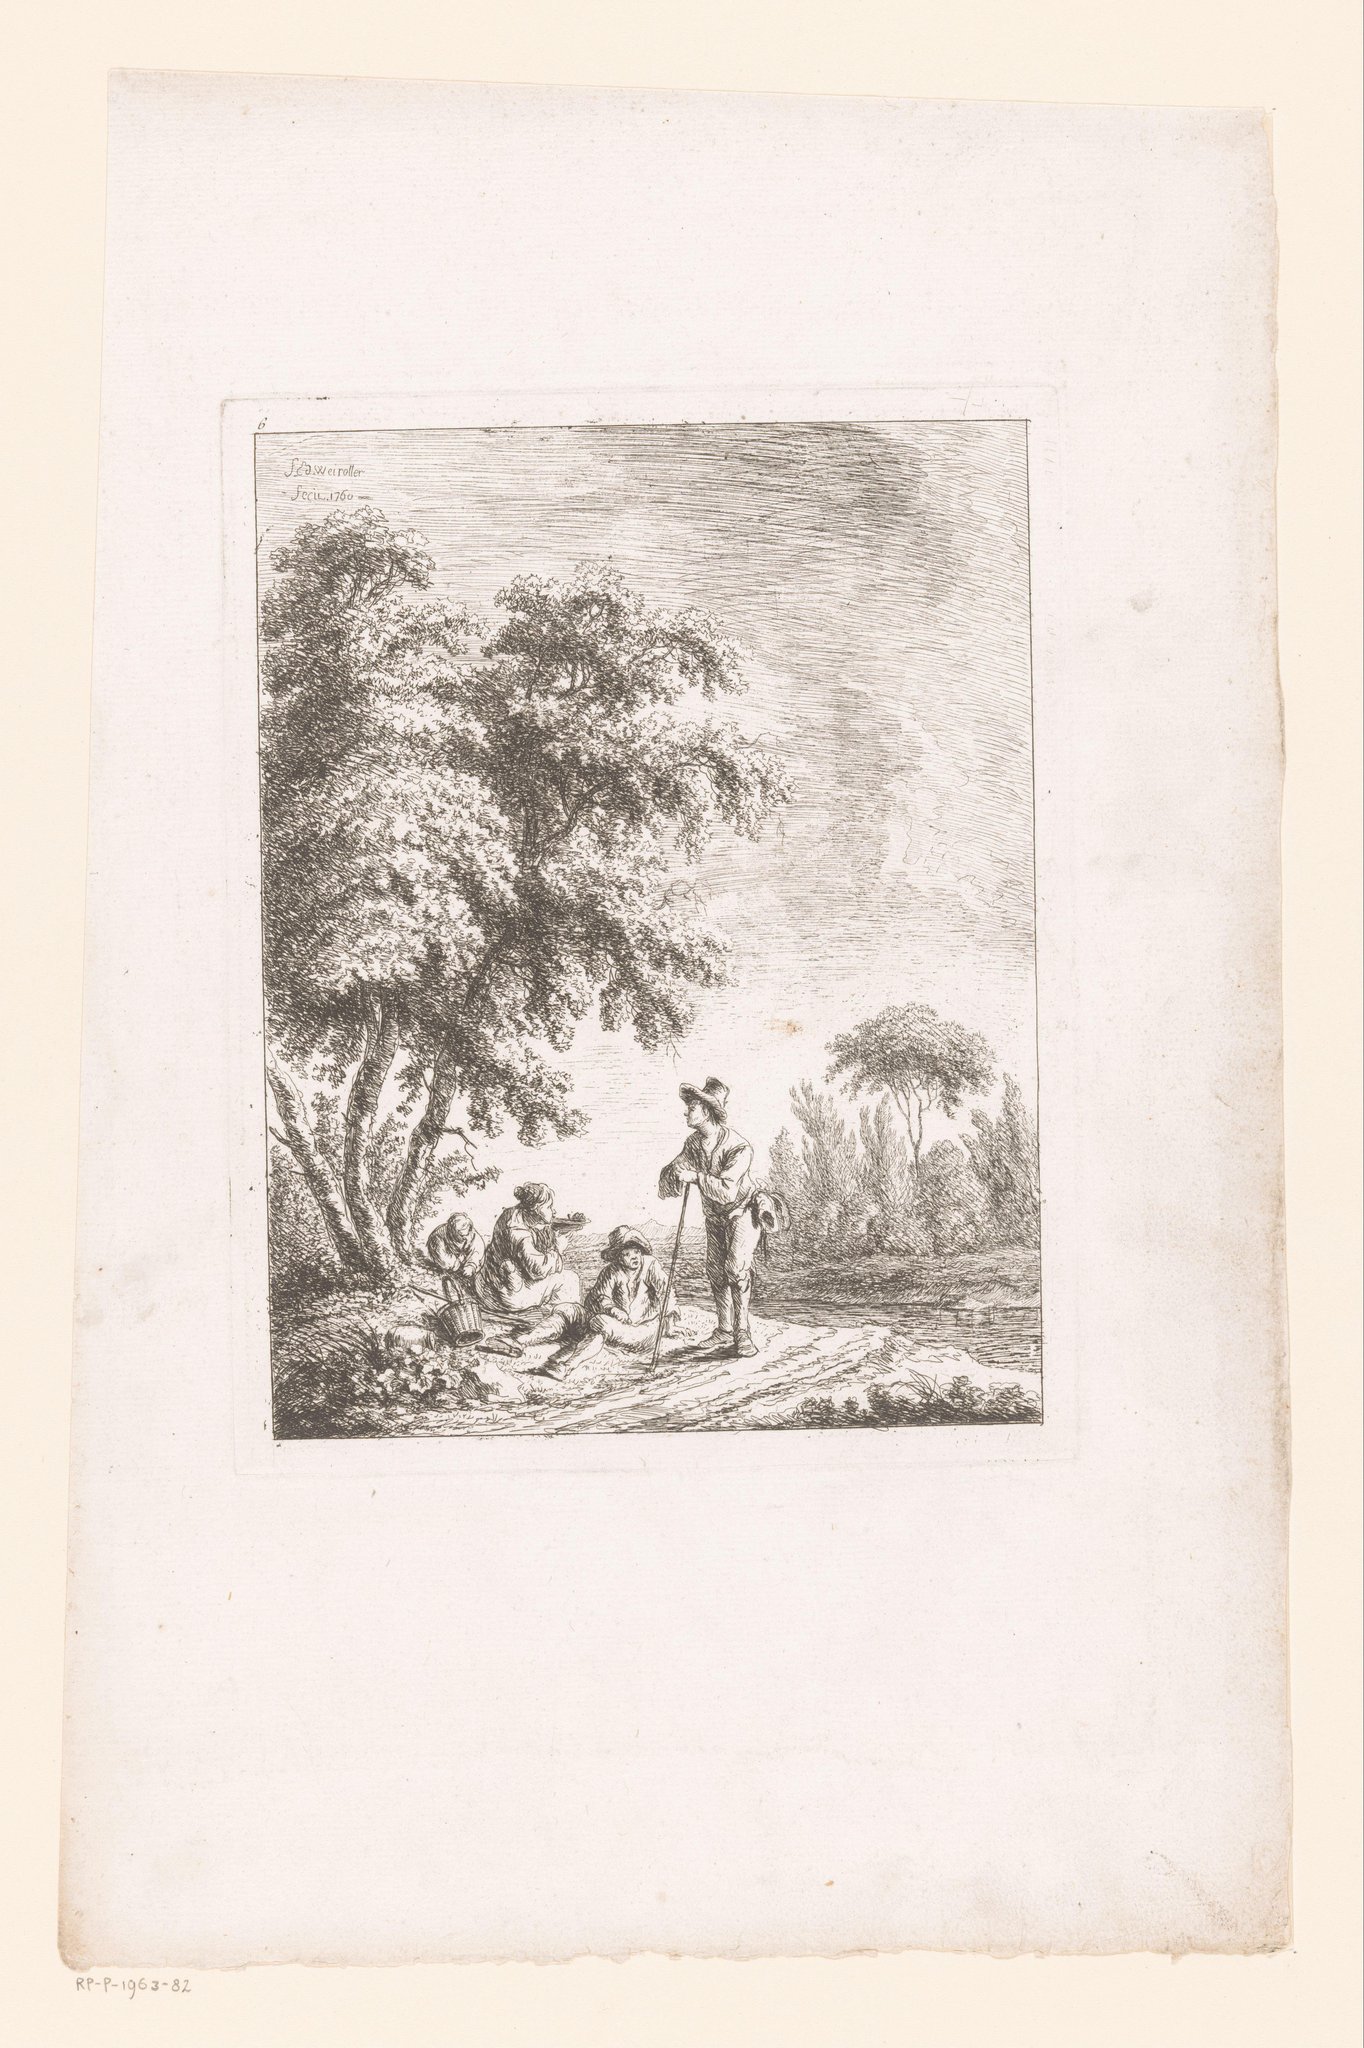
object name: print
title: Deuxième suite des ruines et paysages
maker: franz edmund weirotter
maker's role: draughtsman, painter, print maker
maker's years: 1733-1771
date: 1760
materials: paper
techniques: etching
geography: paris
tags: river, (traveller) resting in the open air, container made of plant material other than wood: basket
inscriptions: collector's mark: Lugt 2760, collector's mark: Lugt 2228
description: Prent maakt deel uit van een serie van zes prenten met landschappen en ruïnes. In de collectie Rijksmuseum bevinden zich vier van de zes prenten (nummers 1, 2, 3 en 6).